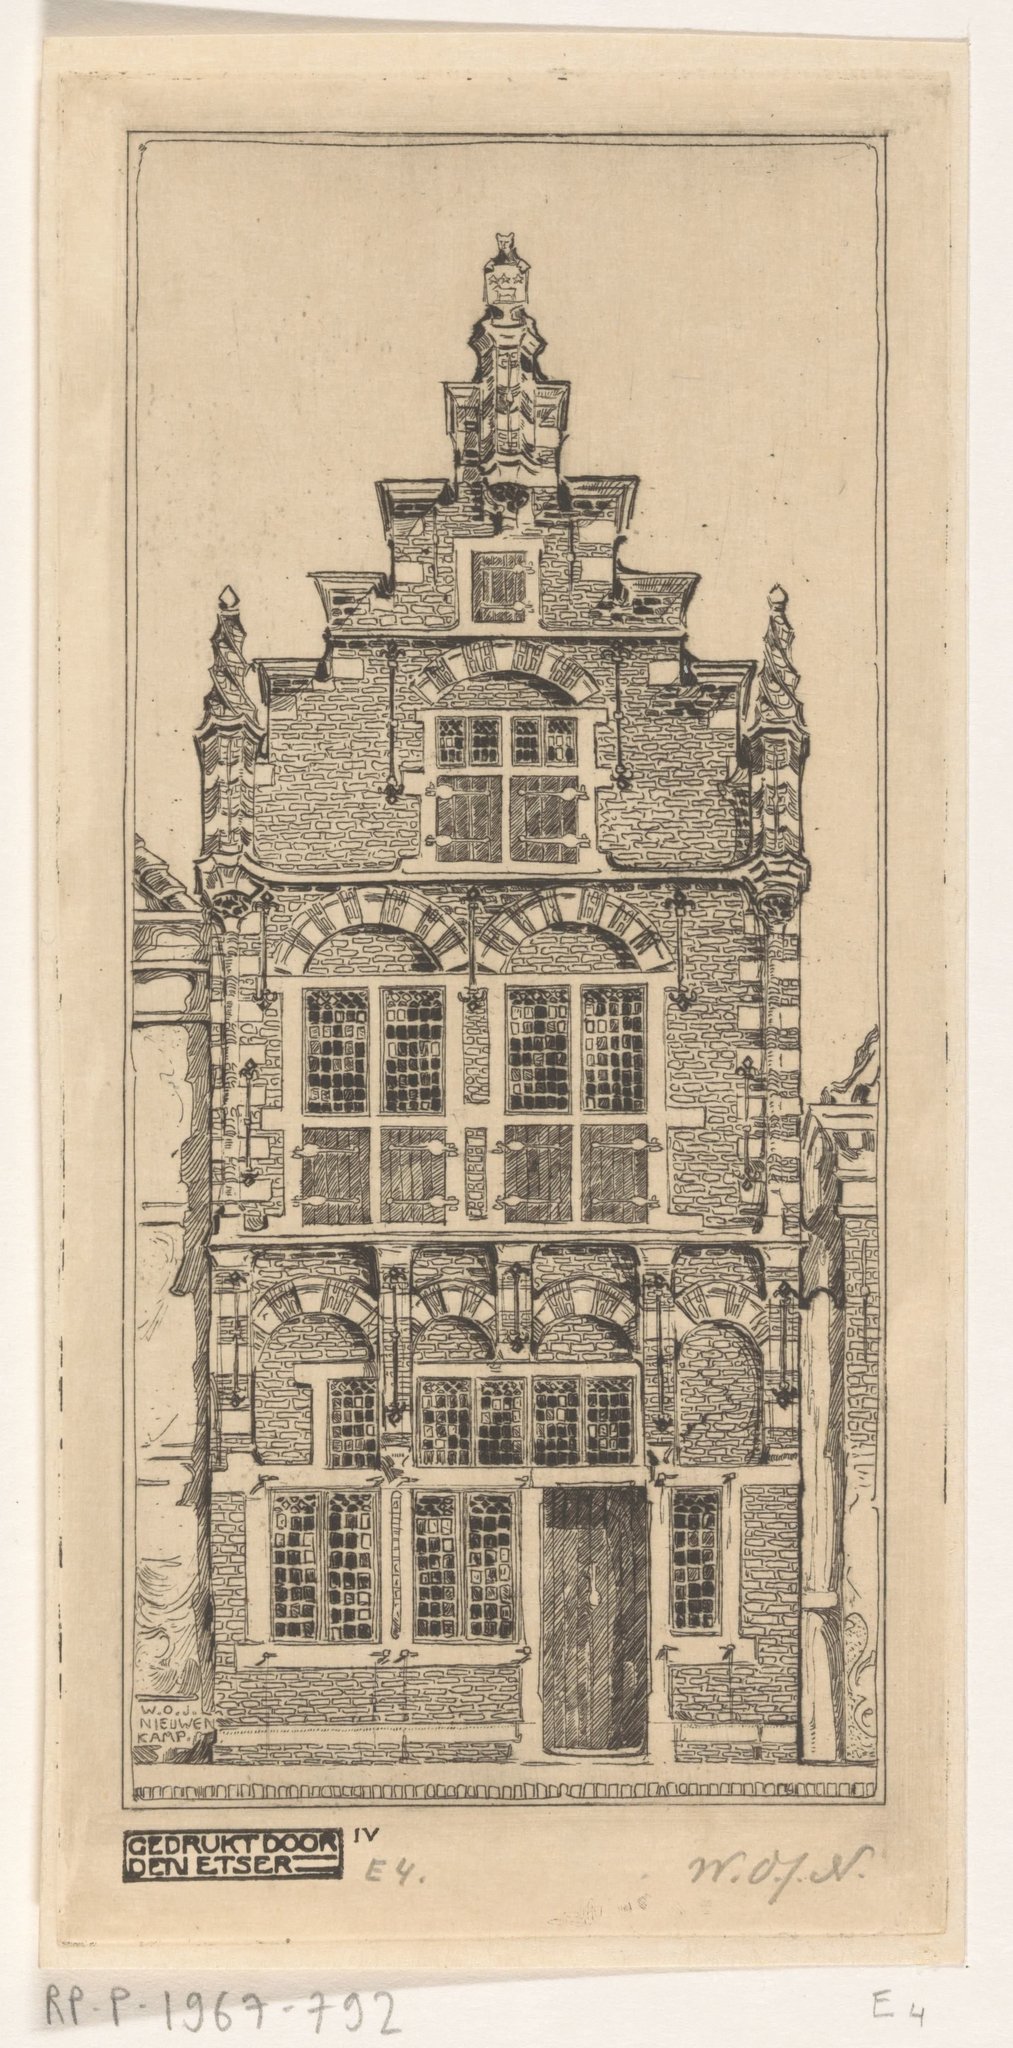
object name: print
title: Voorgevel van het Edams Museum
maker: wijnand otto jan nieuwenkamp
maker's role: draughtsman, print maker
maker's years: 1874-1950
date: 1896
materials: paper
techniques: zinc etching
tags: permanent exhibition, museum, front façade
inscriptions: collector's mark: Lugt 2228, collector's mark: Lugt 2760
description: Het Edams Museum is gevestigd in het Steenen Coopmanshuys, gelegen aan de Damsluis in Edam.